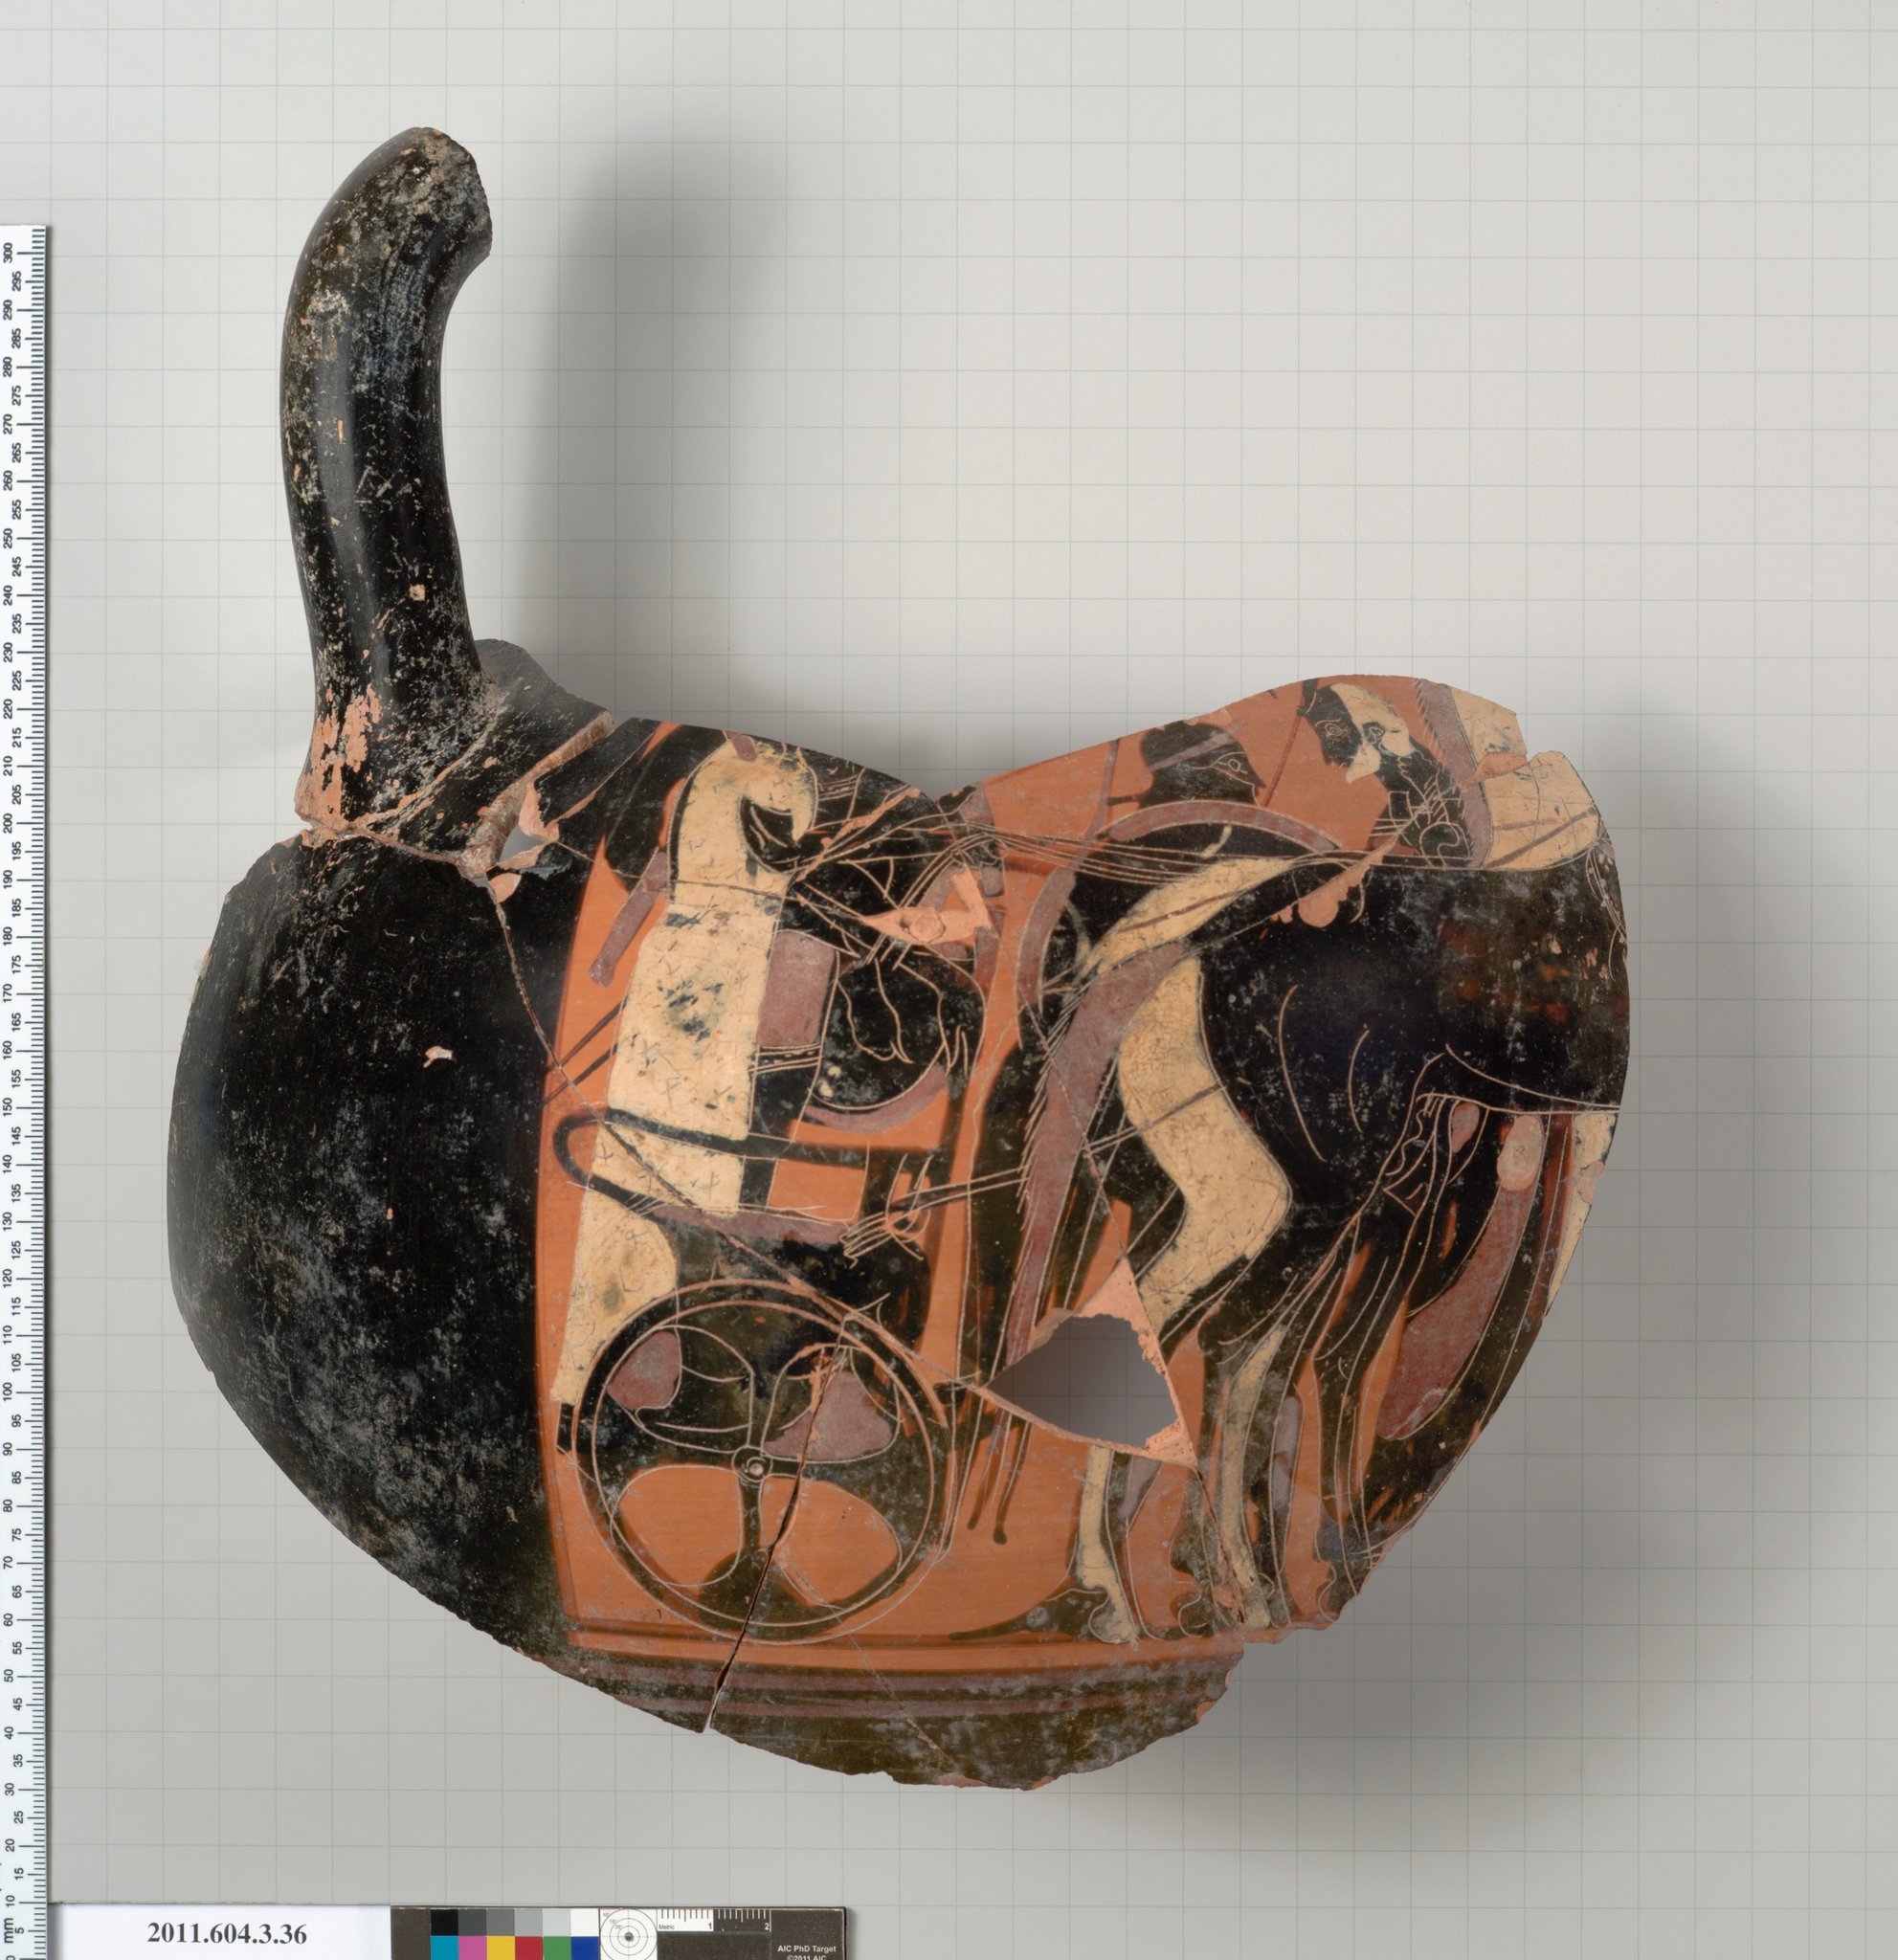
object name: amphora fragment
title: Terracotta fragment of an amphora (jar)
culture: greek, attic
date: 550-526 BCE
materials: terracotta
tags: horses,chariots